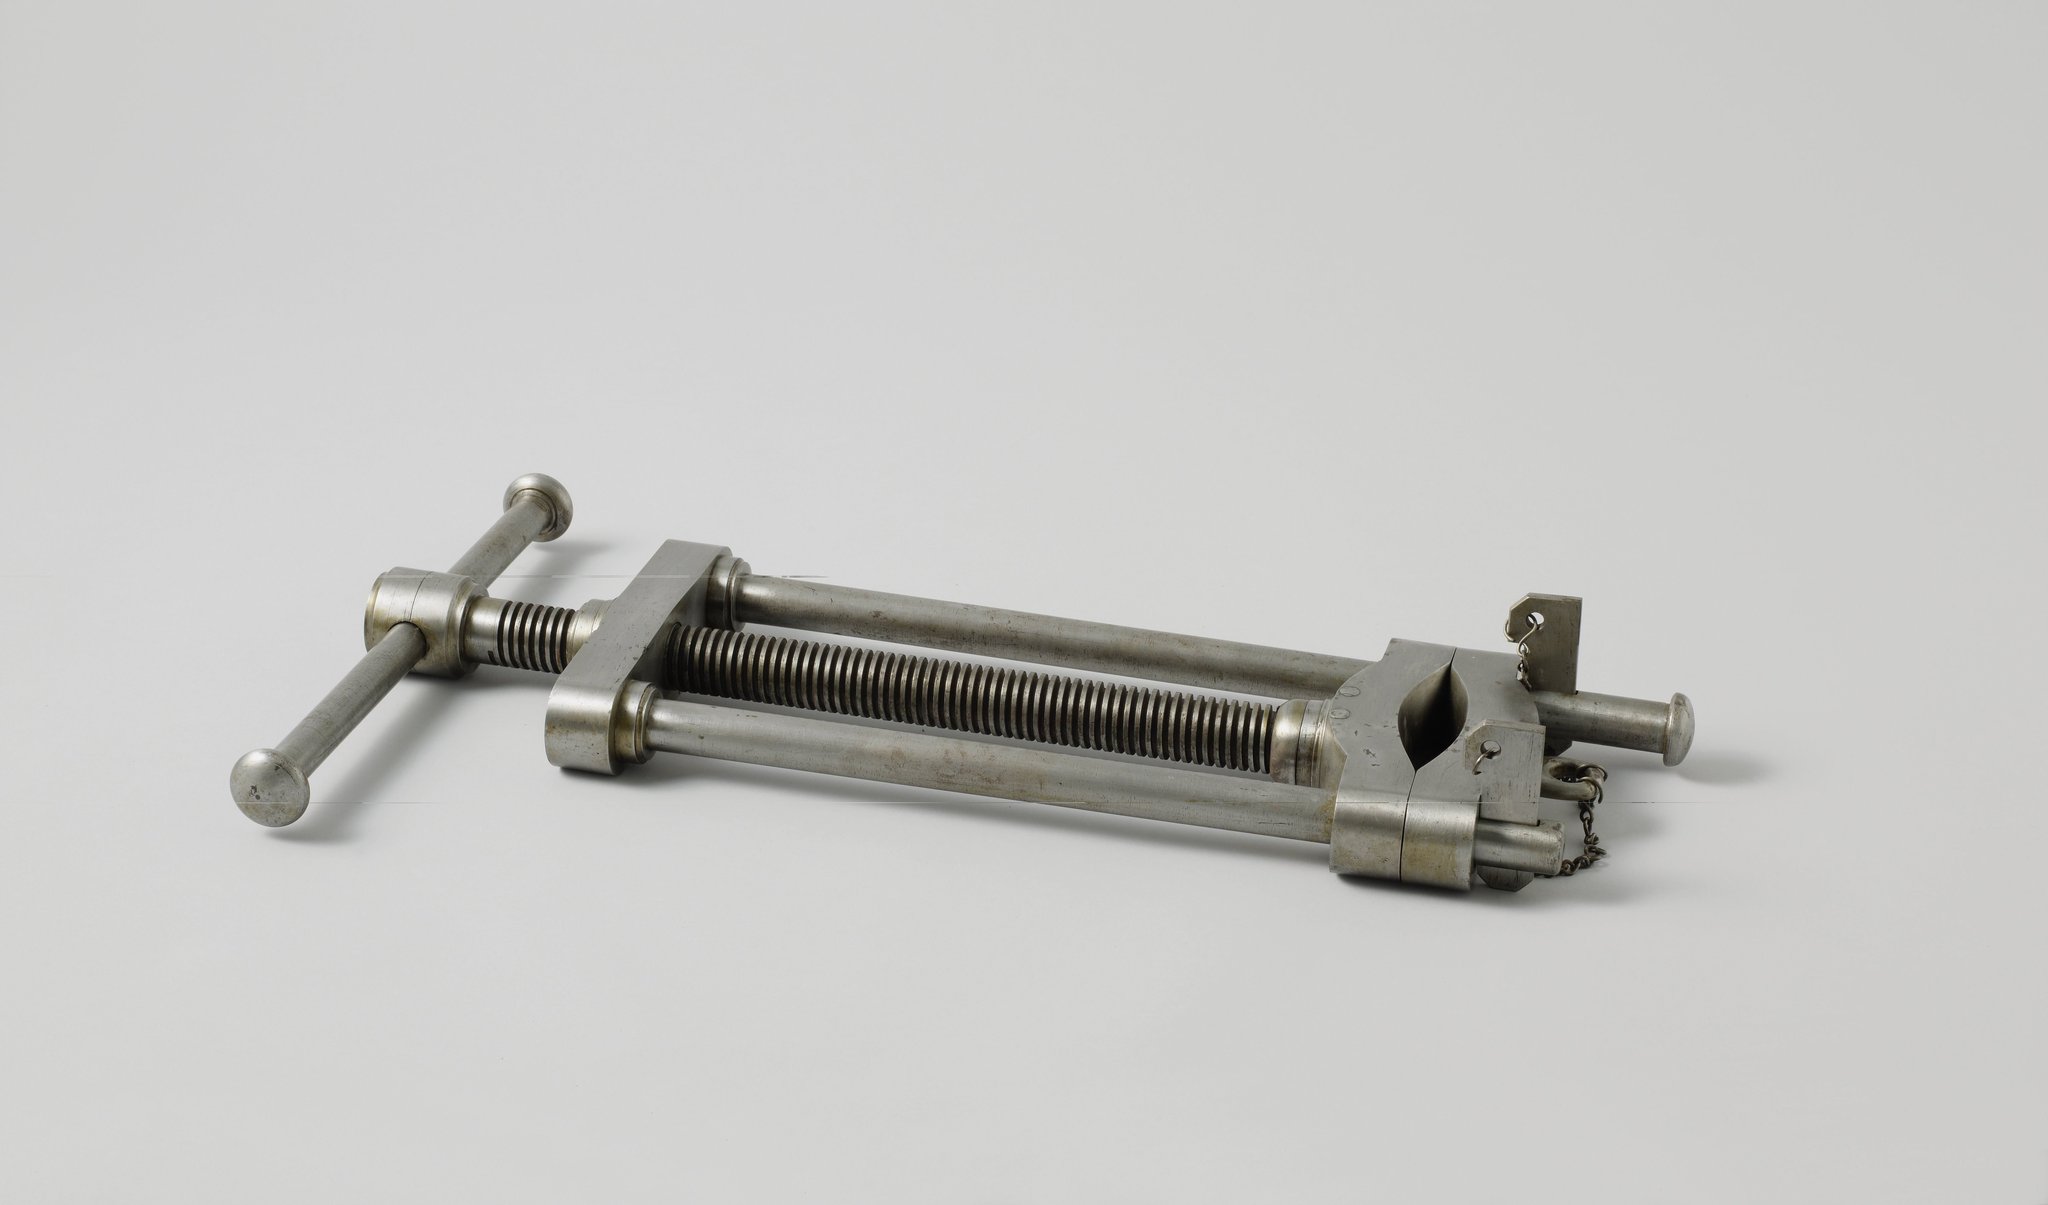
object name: rigging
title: Rigger's Screw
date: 1851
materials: iron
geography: hellevoetsluis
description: Wantklem of -knijper om het hoofdtouw om de kous of het jufferblok te klemmen tijdens het aanbrengen van het bindsel. Het bestaat uit een soort bankschroef op twee glijstangen.